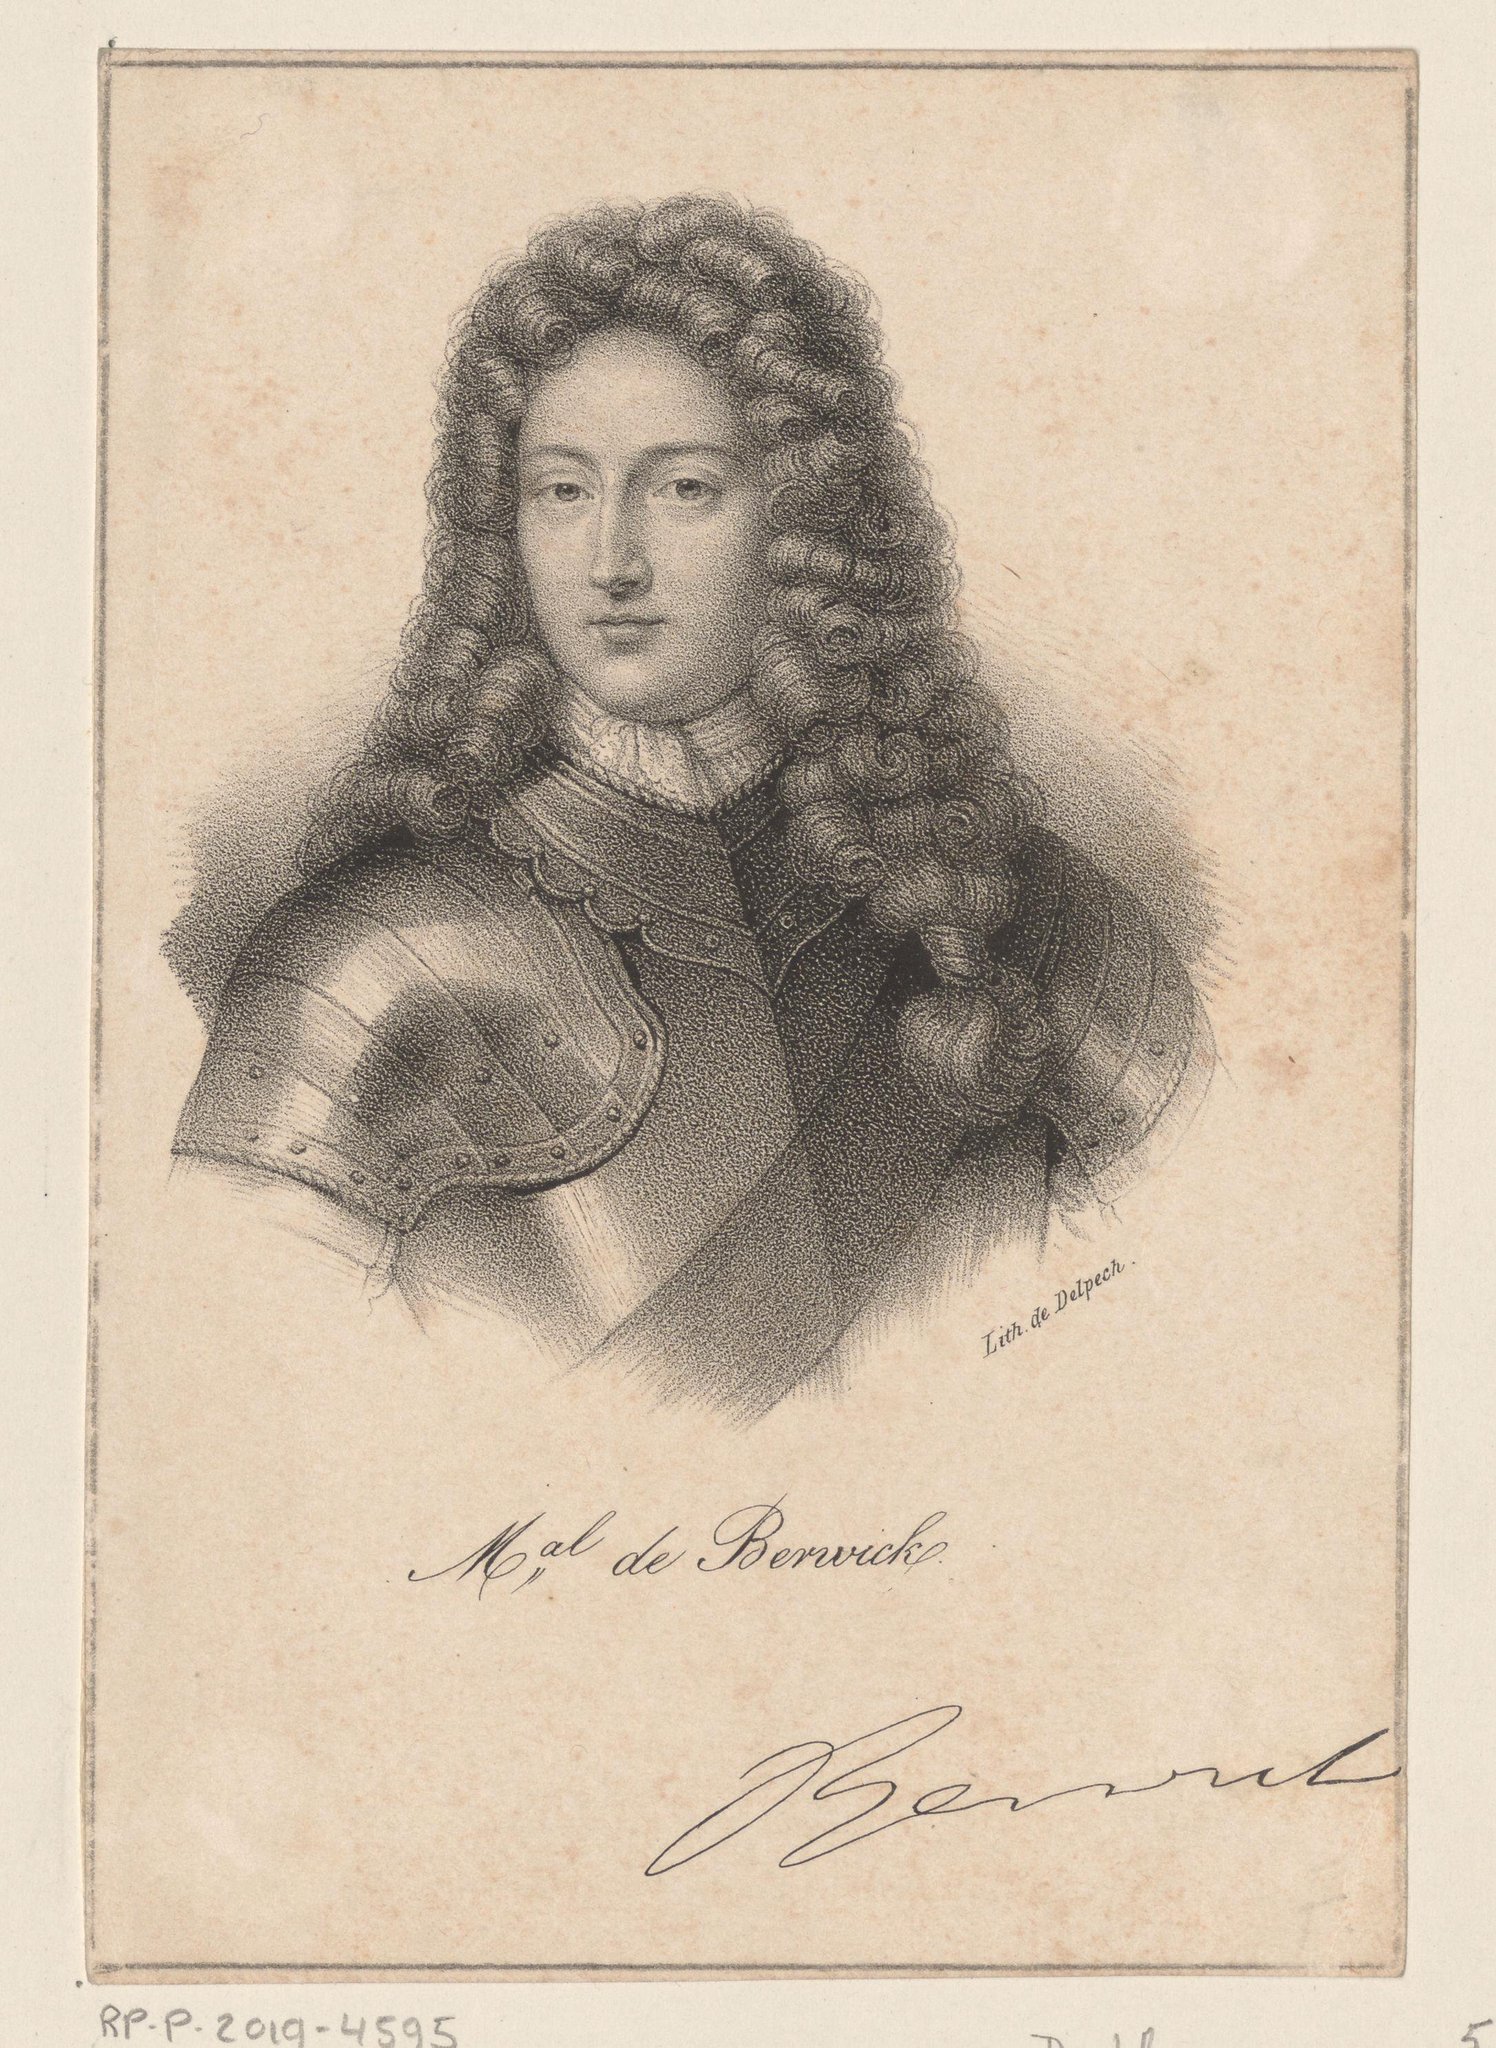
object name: print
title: Portret van James FitzJames, hertog van Berwick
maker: Anonymous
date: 1818-1842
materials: paper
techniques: lithograph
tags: armour, historical persons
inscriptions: collector's mark: Lugt 2228